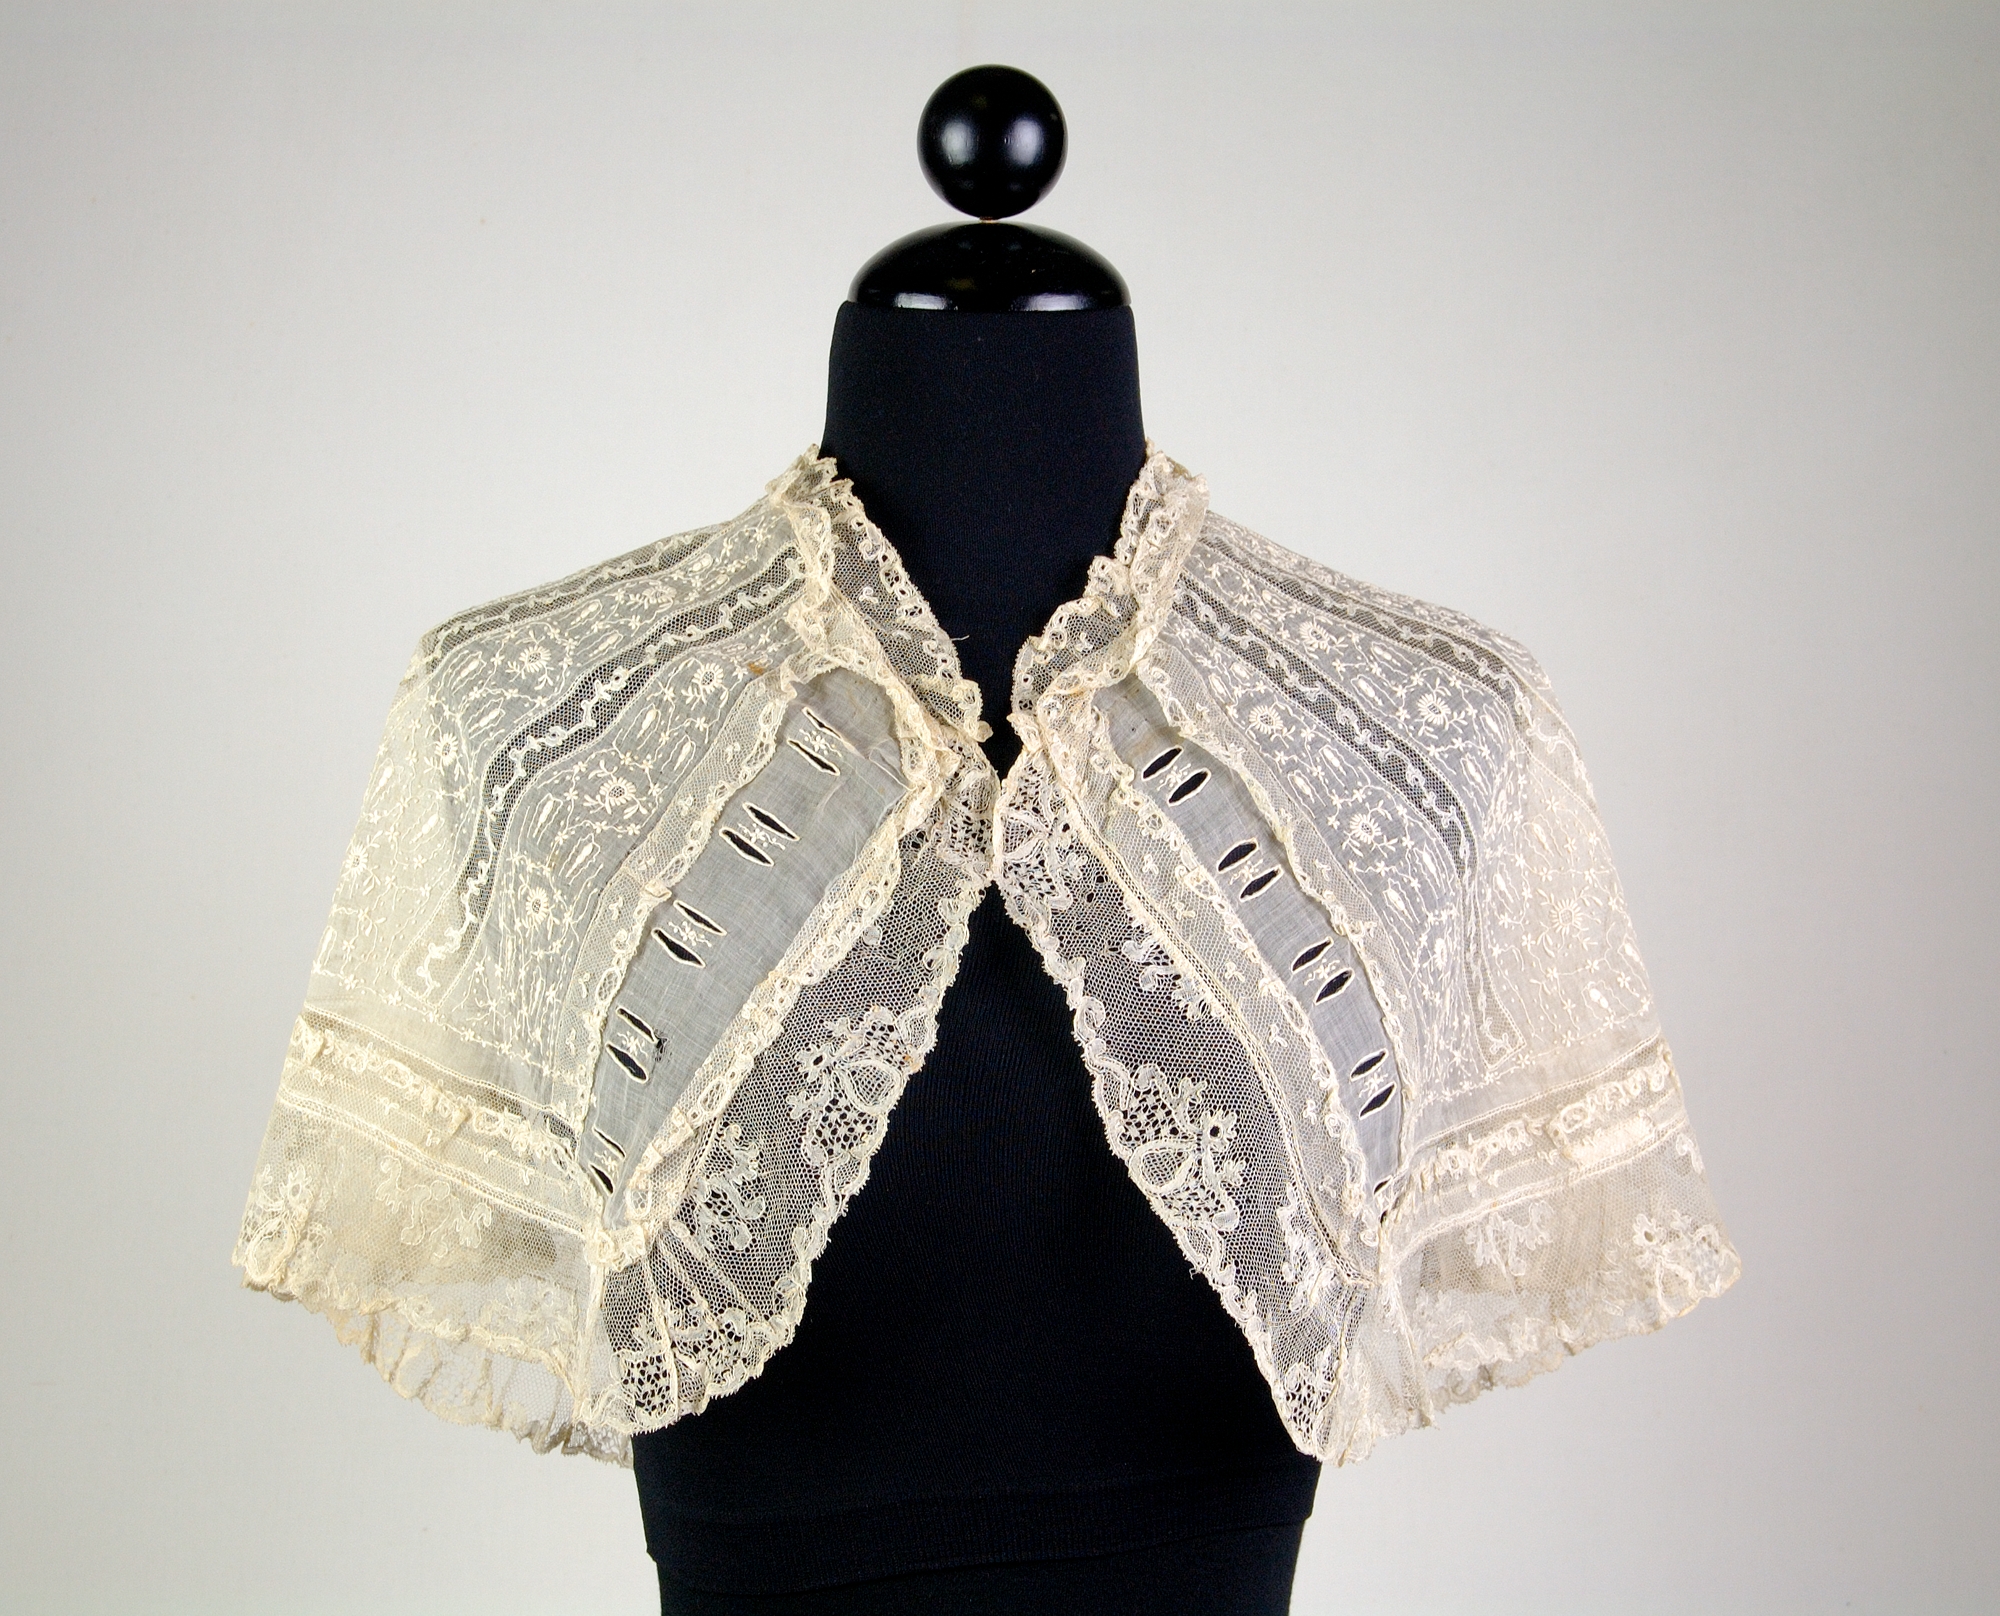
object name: collar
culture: french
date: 1835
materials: cotton